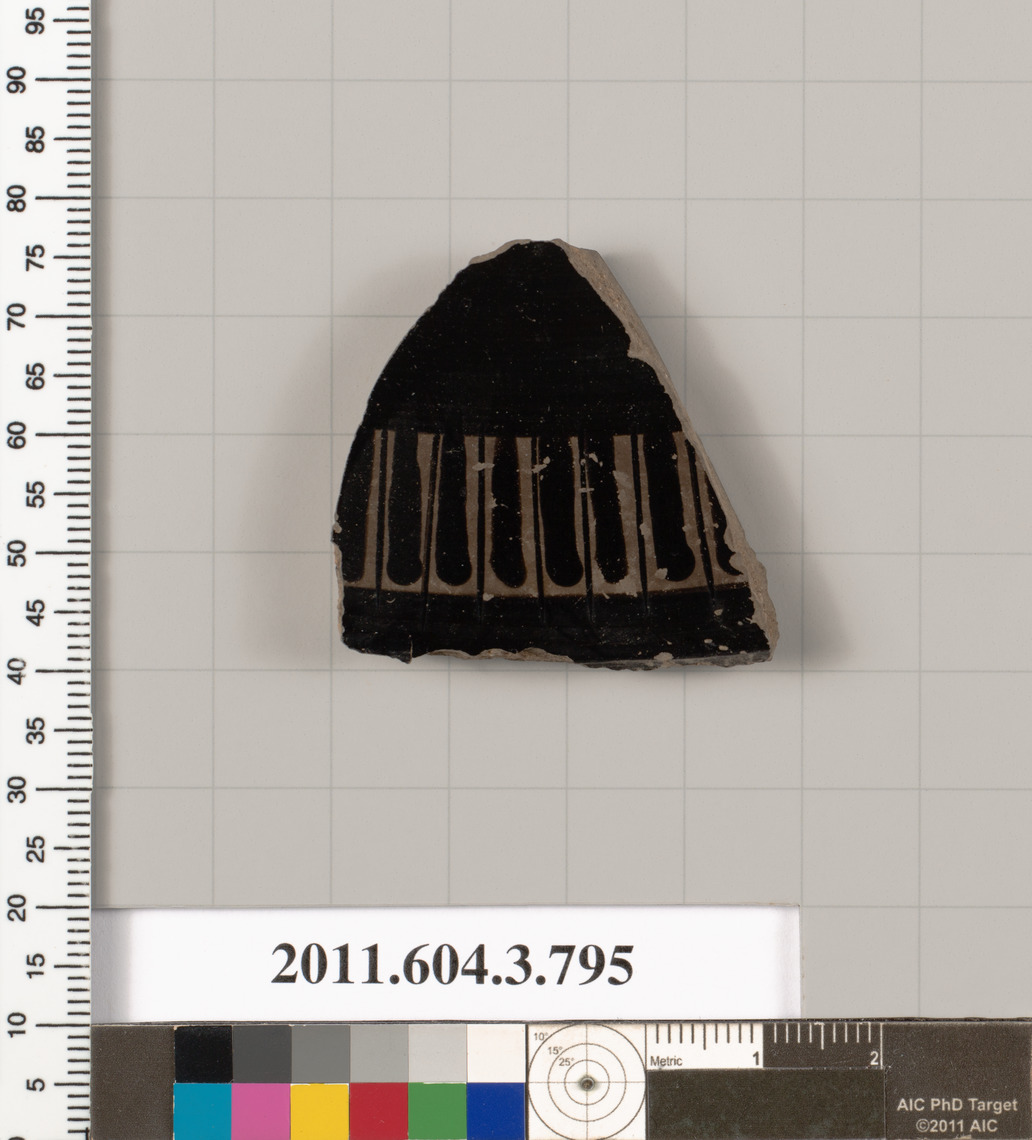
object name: lid fragment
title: Terracotta fragment of a lid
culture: greek, attic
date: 600-501 BCE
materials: terracotta